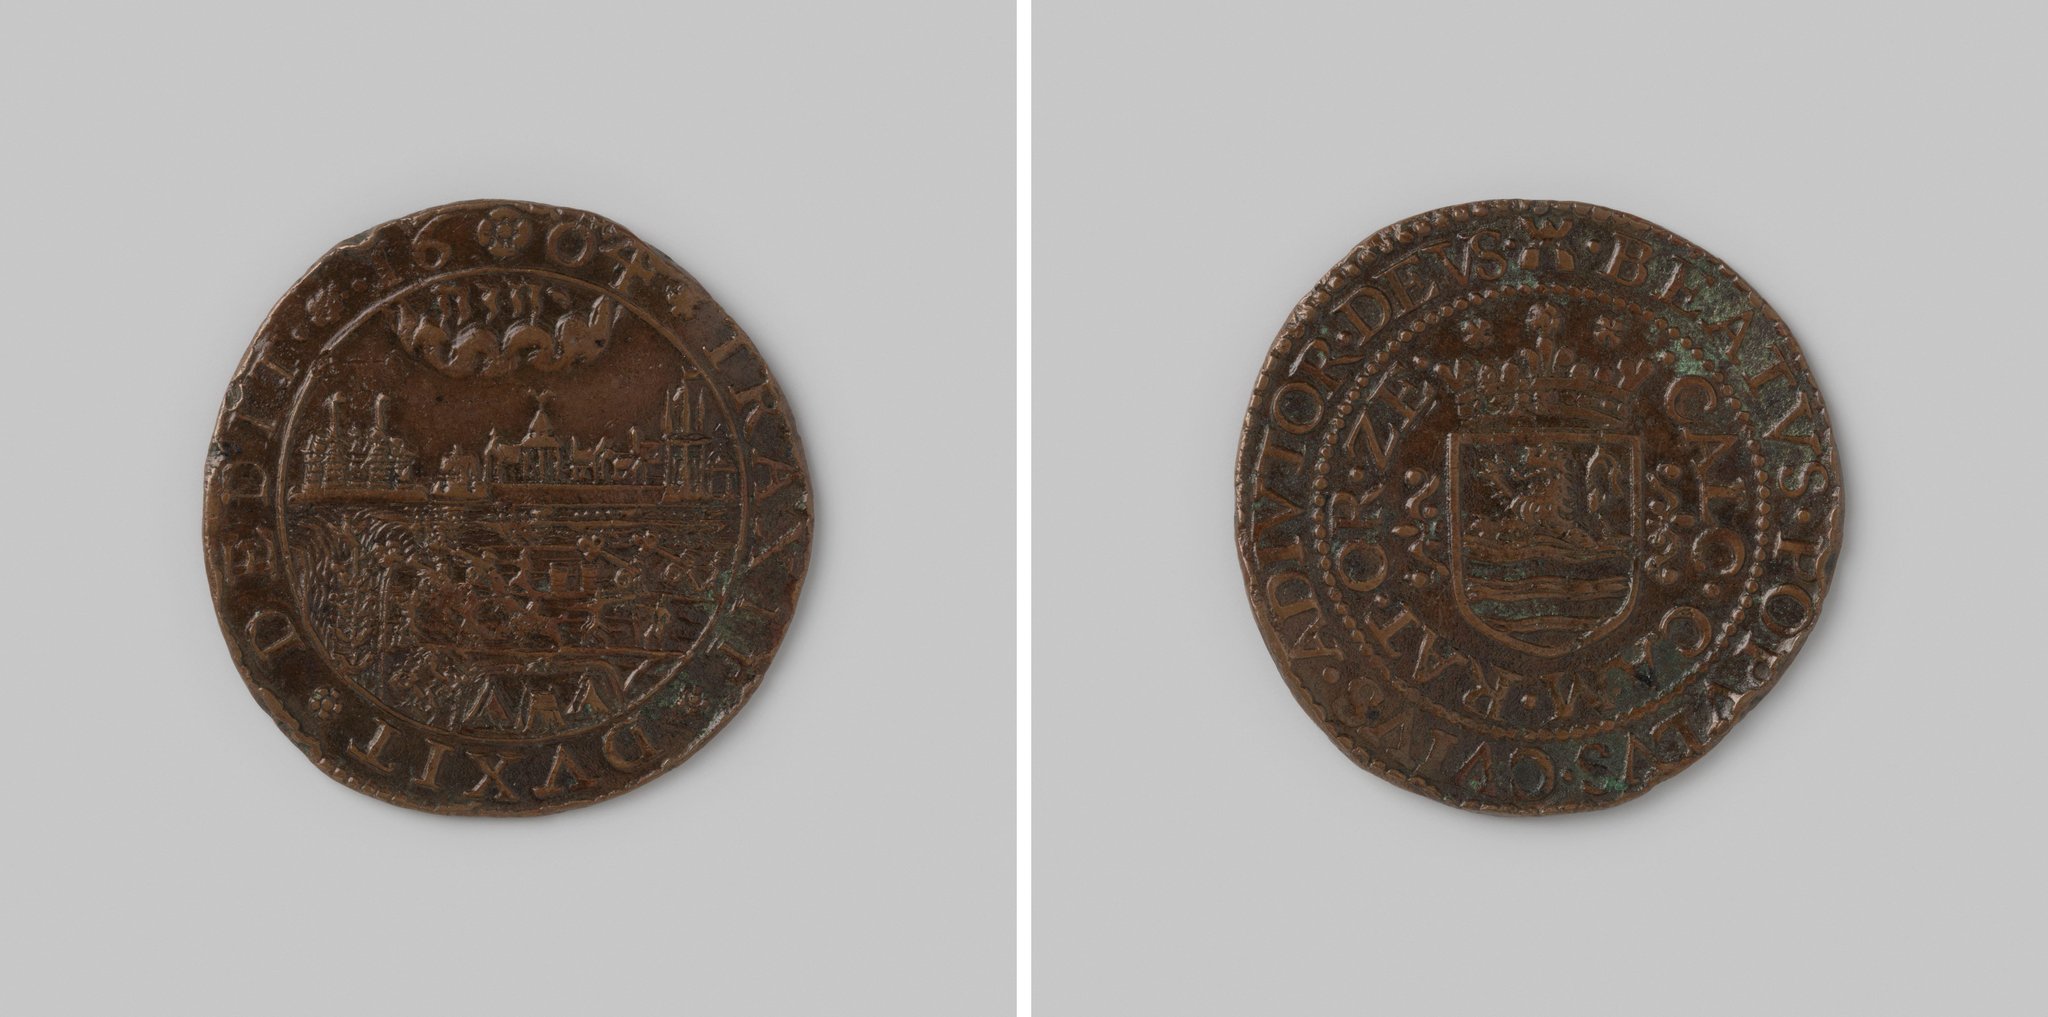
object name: jeton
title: Rekenpenning uit Middelburg voor de Rekenkamer van Zeeland op de inname van Sluis 1604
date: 1604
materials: copper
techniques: striking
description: Koperen penning, op de voorzijde het aanzicht van de belegerde stad,met omschrift, op de keerzijde het gekroonde wapenschild van Zeeland met dubbel omschrift, gescheiden door een parelcirkel.